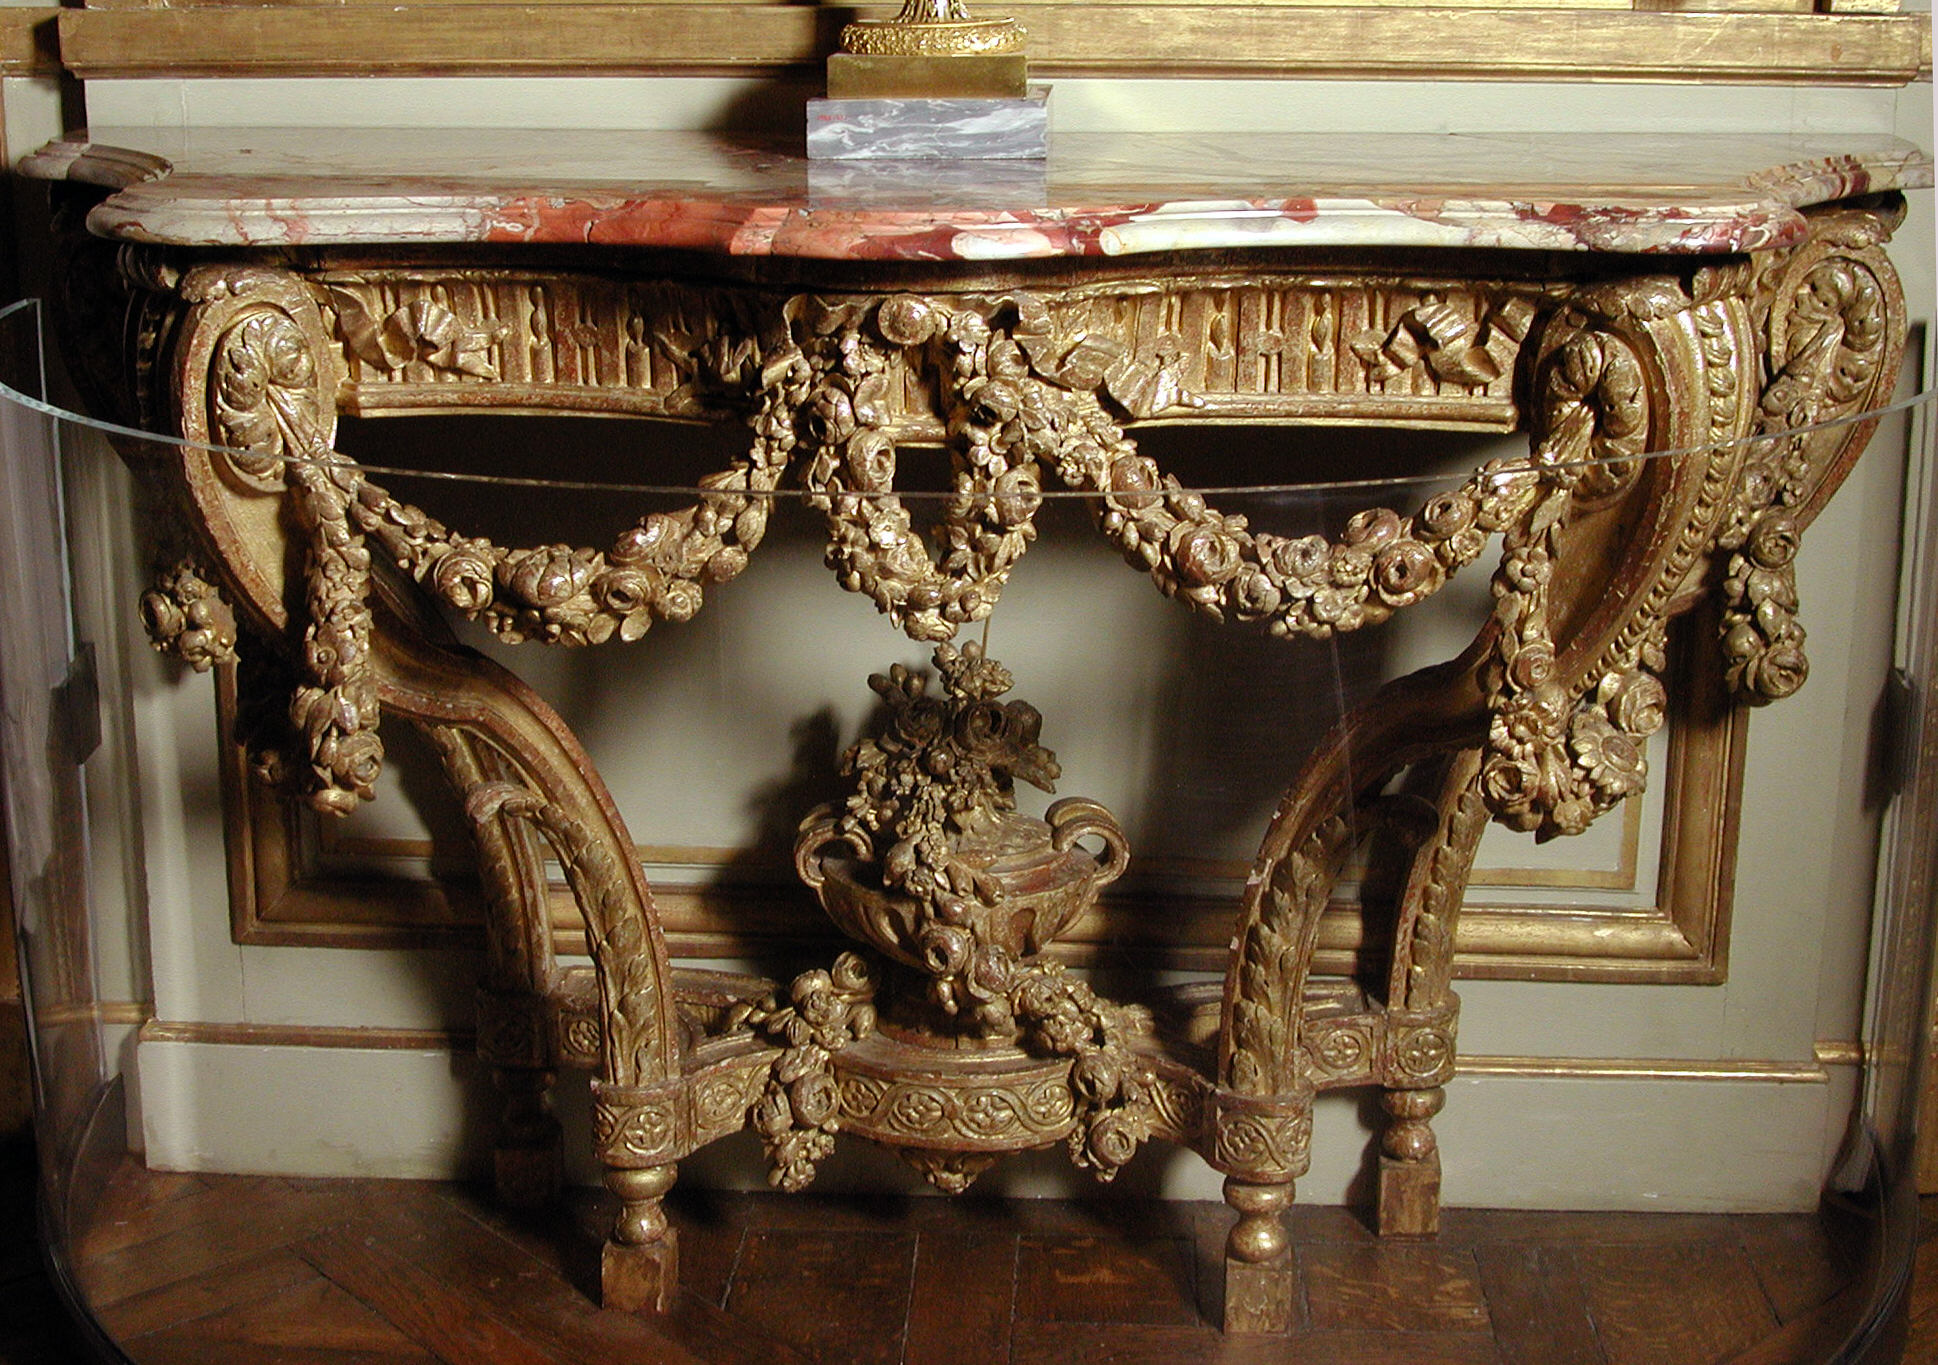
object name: console table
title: Console table (one of a pair)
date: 1765-1770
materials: marble, wood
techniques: carving, gilding